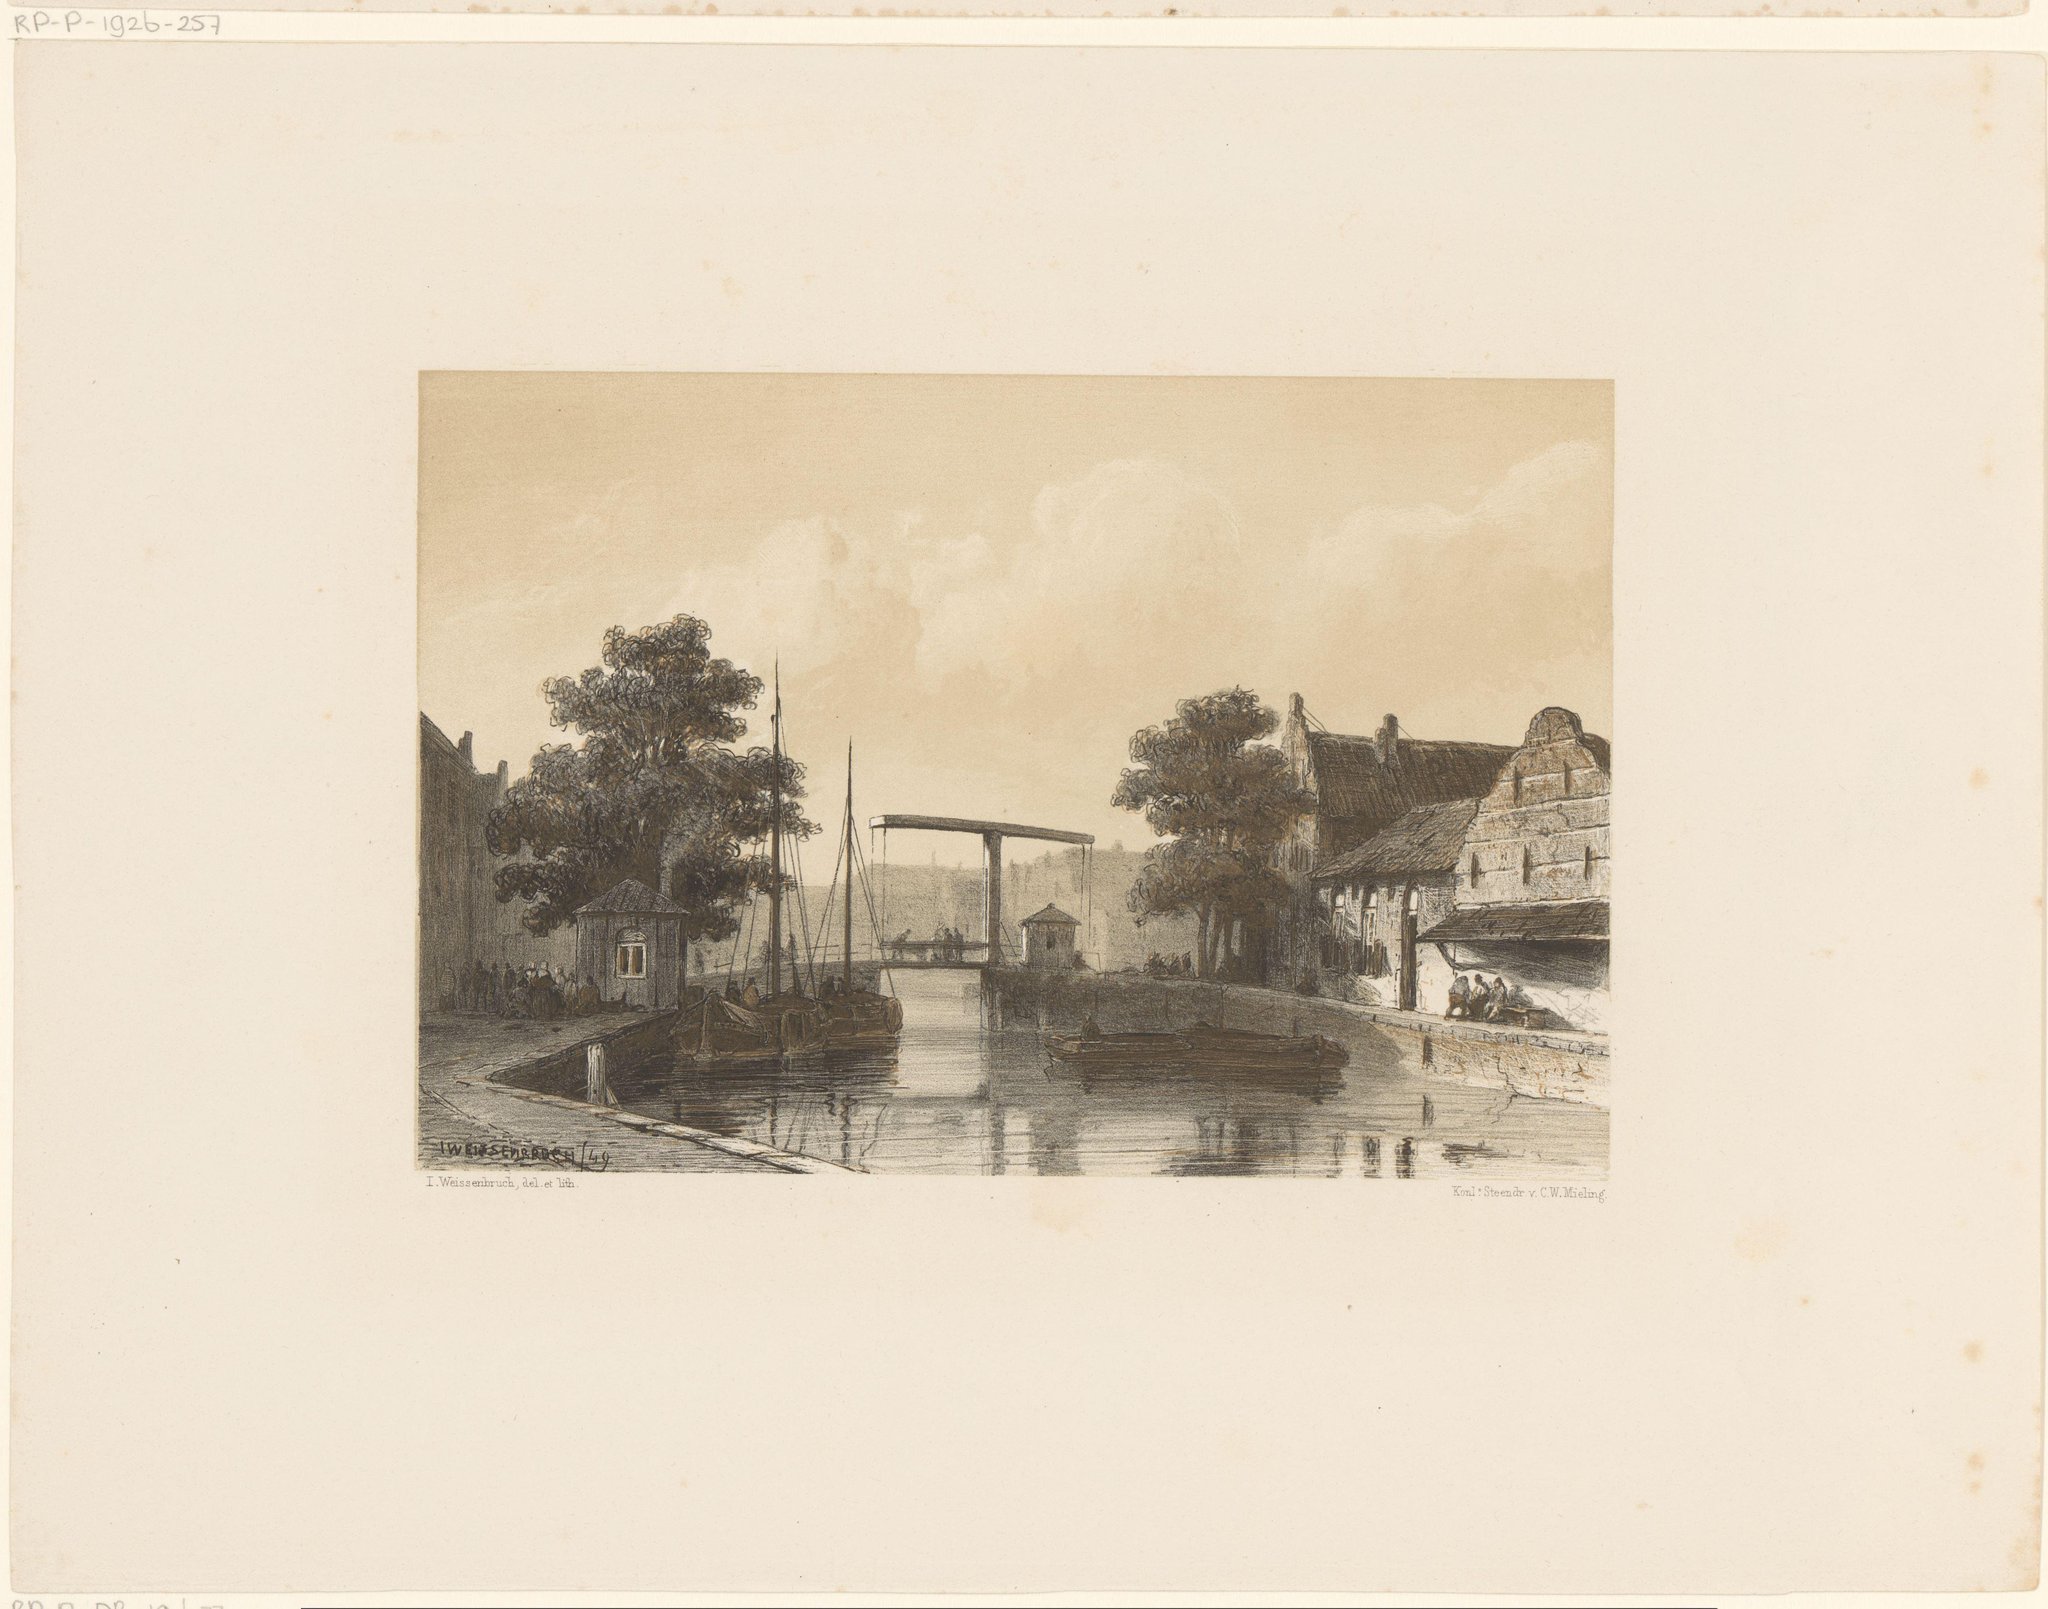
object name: print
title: Gezicht op vaart met ophaalbrug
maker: jan weissenbruch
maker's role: painter, print maker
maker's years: 1822-1880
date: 1849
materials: paper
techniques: tone lithography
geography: the hague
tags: canal, bridge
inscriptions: collector's mark: Lugt 2228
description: Mensen lopen op de kade en brug bij een vaart. Op de vaart liggen boten.